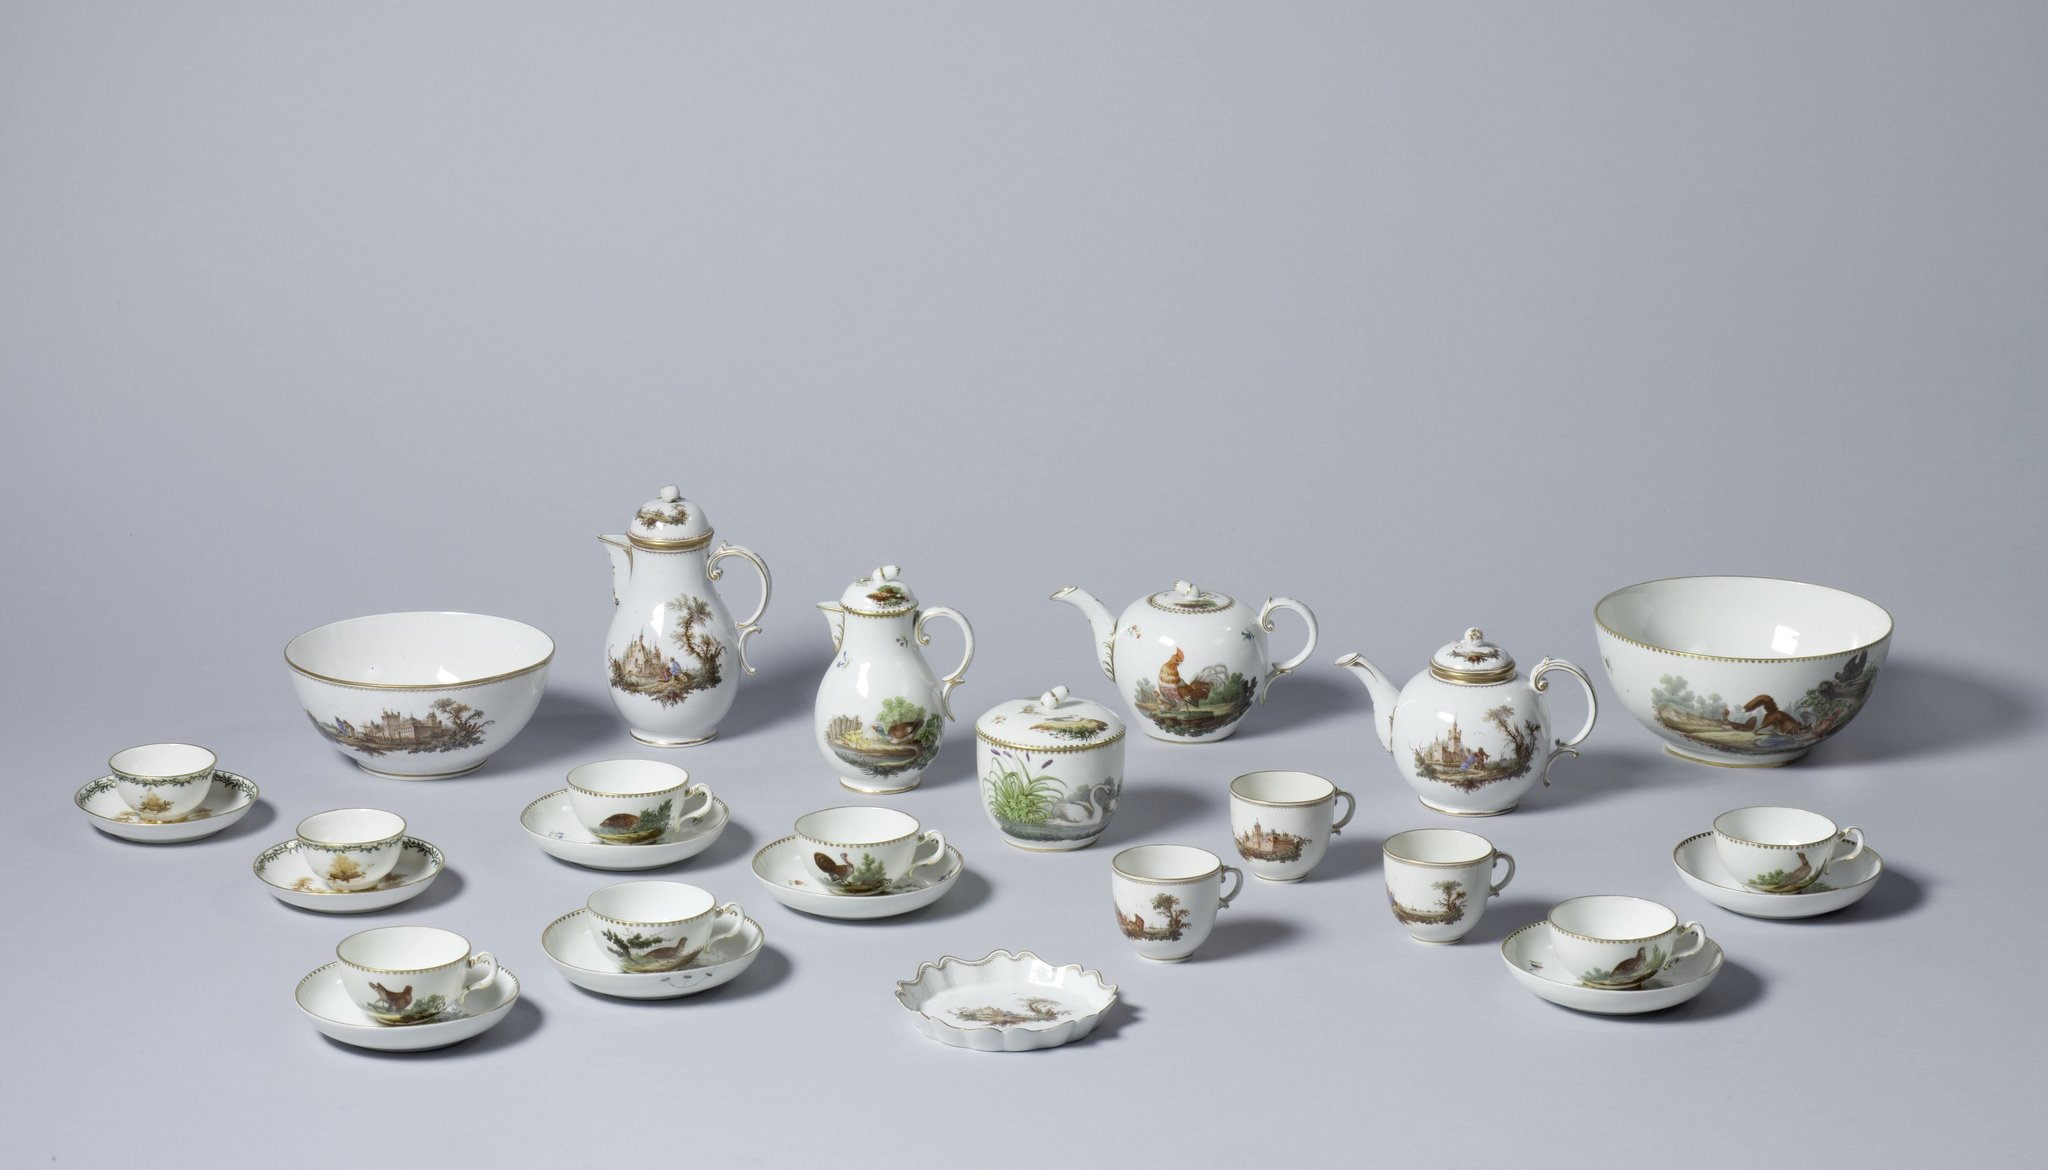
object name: tea service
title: Koffie- en theeservies, beschilderd met waterlandschappen met kastelen/paleizen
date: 1778-1782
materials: porcelain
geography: loosdrecht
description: Parts of a tea and coffee service. Porcelain. Loosdrecht, c. 1776 - 1780. Factory of Joannes de Mol.